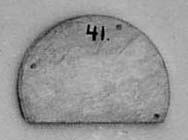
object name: medallion, fragment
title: Part of a Circular Medallion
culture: burmese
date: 1902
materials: jade